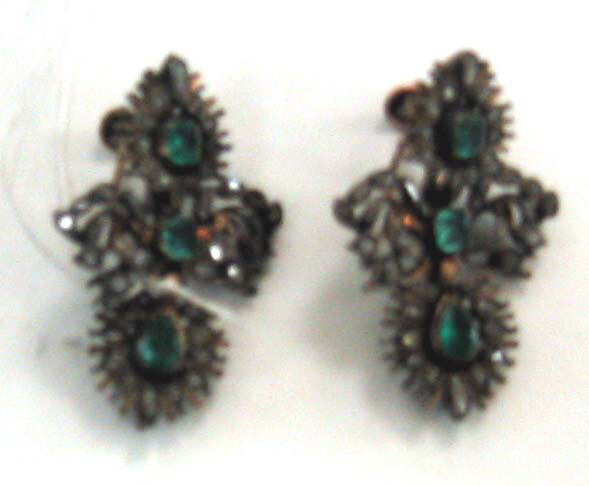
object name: jewelry set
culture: american or european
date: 1850-1875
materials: diamond, silver